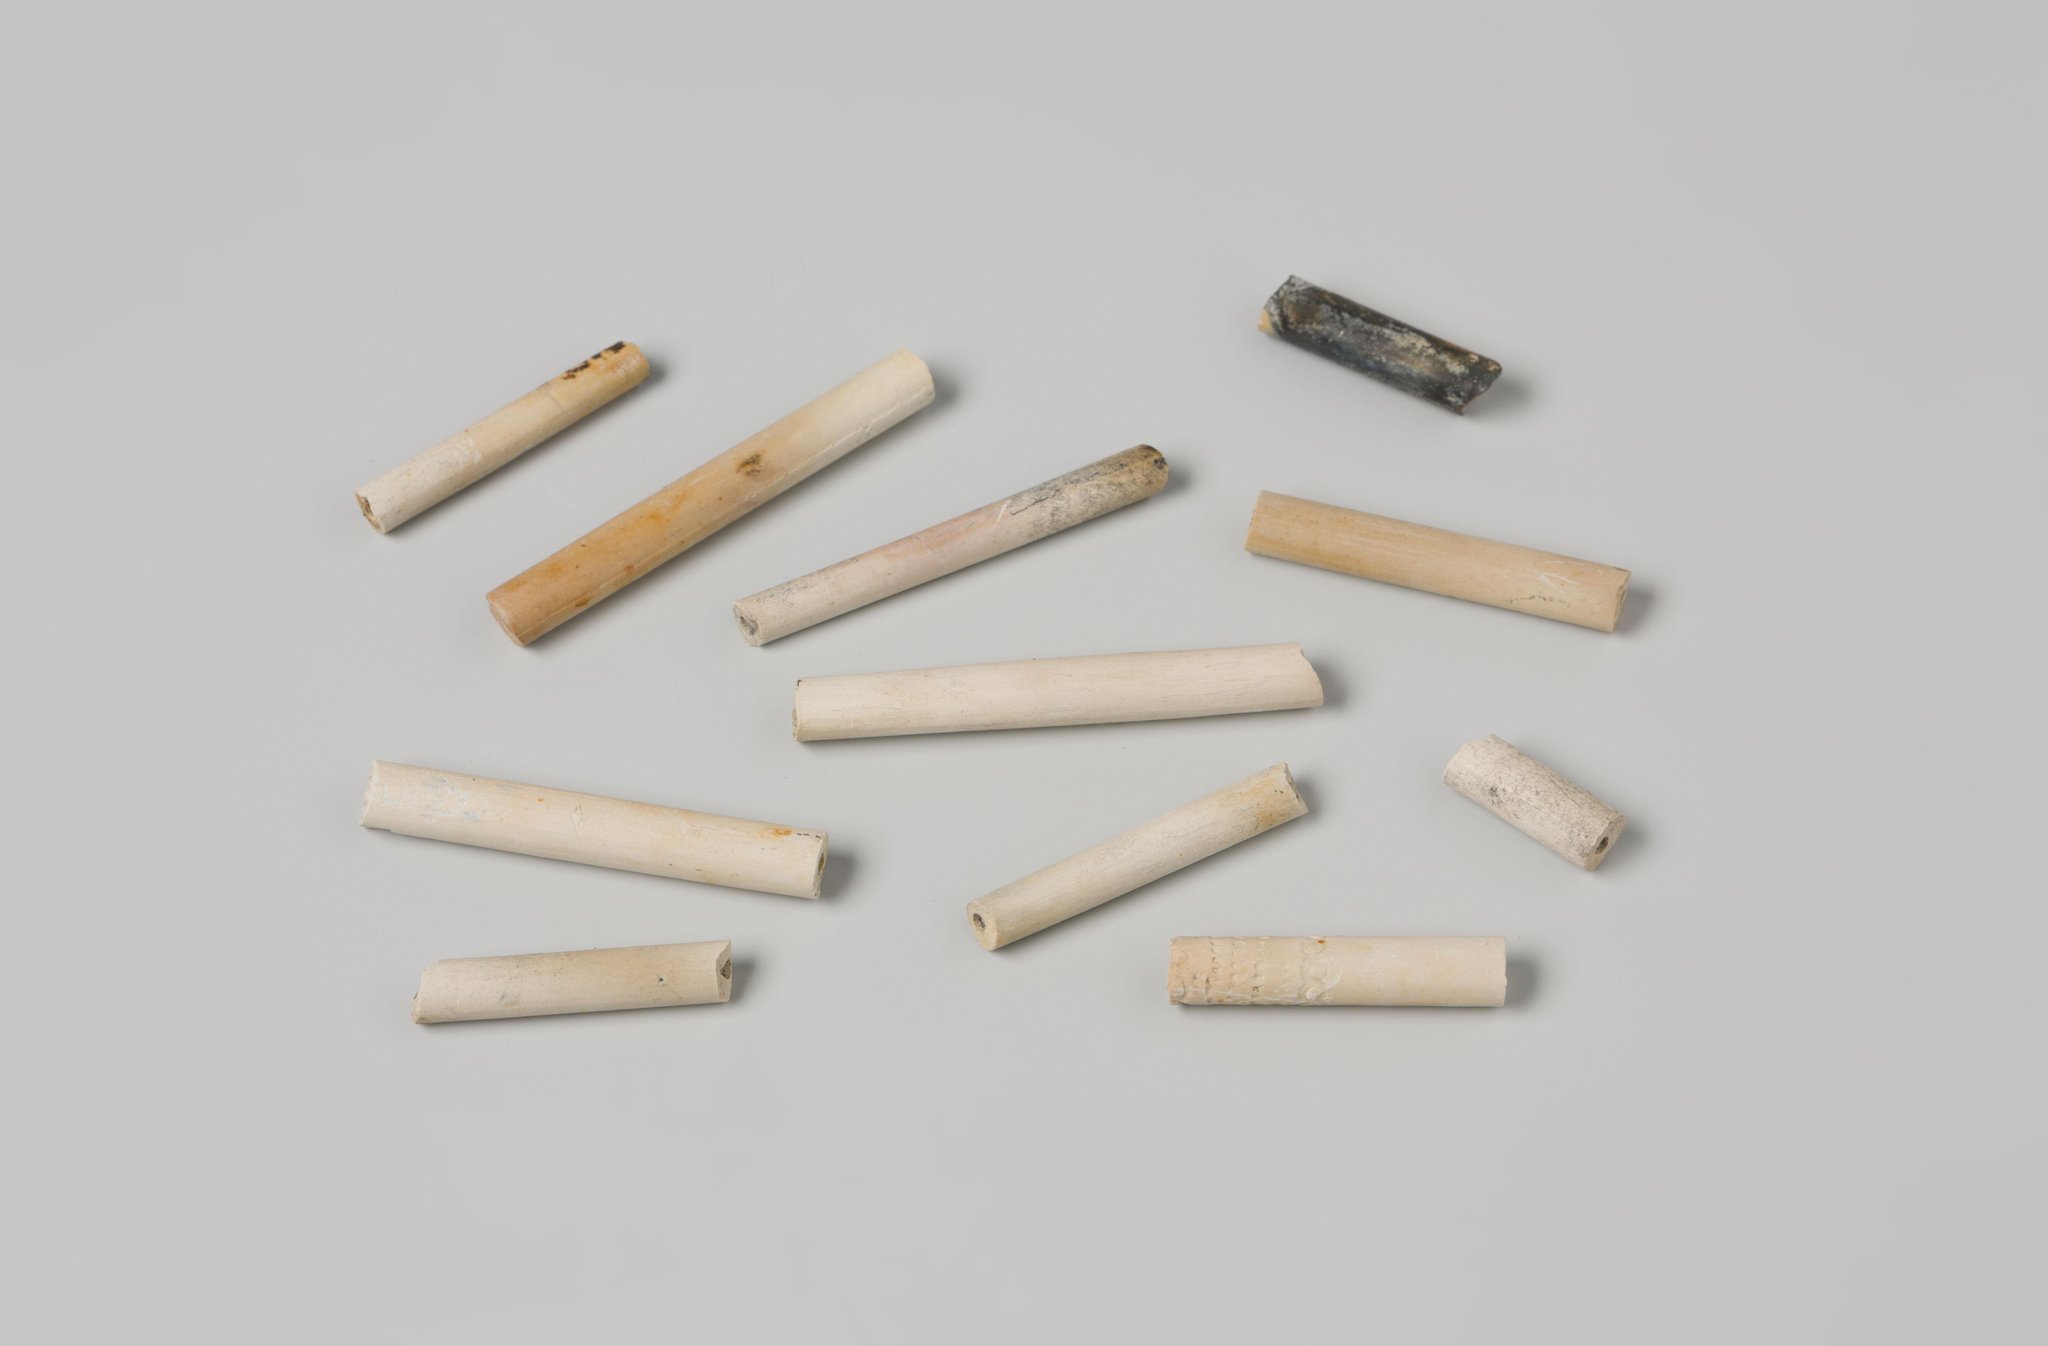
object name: pipe stem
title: Fragment pijpenstelen uit het wrak van de Oost-Indiëvaarder 't Vliegend Hart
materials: clay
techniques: firing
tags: 't vliegend hart (schip), verenigde oostindische compagnie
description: Elf stukken steel van aarden Goudse pijpen, deels versierd. Fragments of bowls and stems.